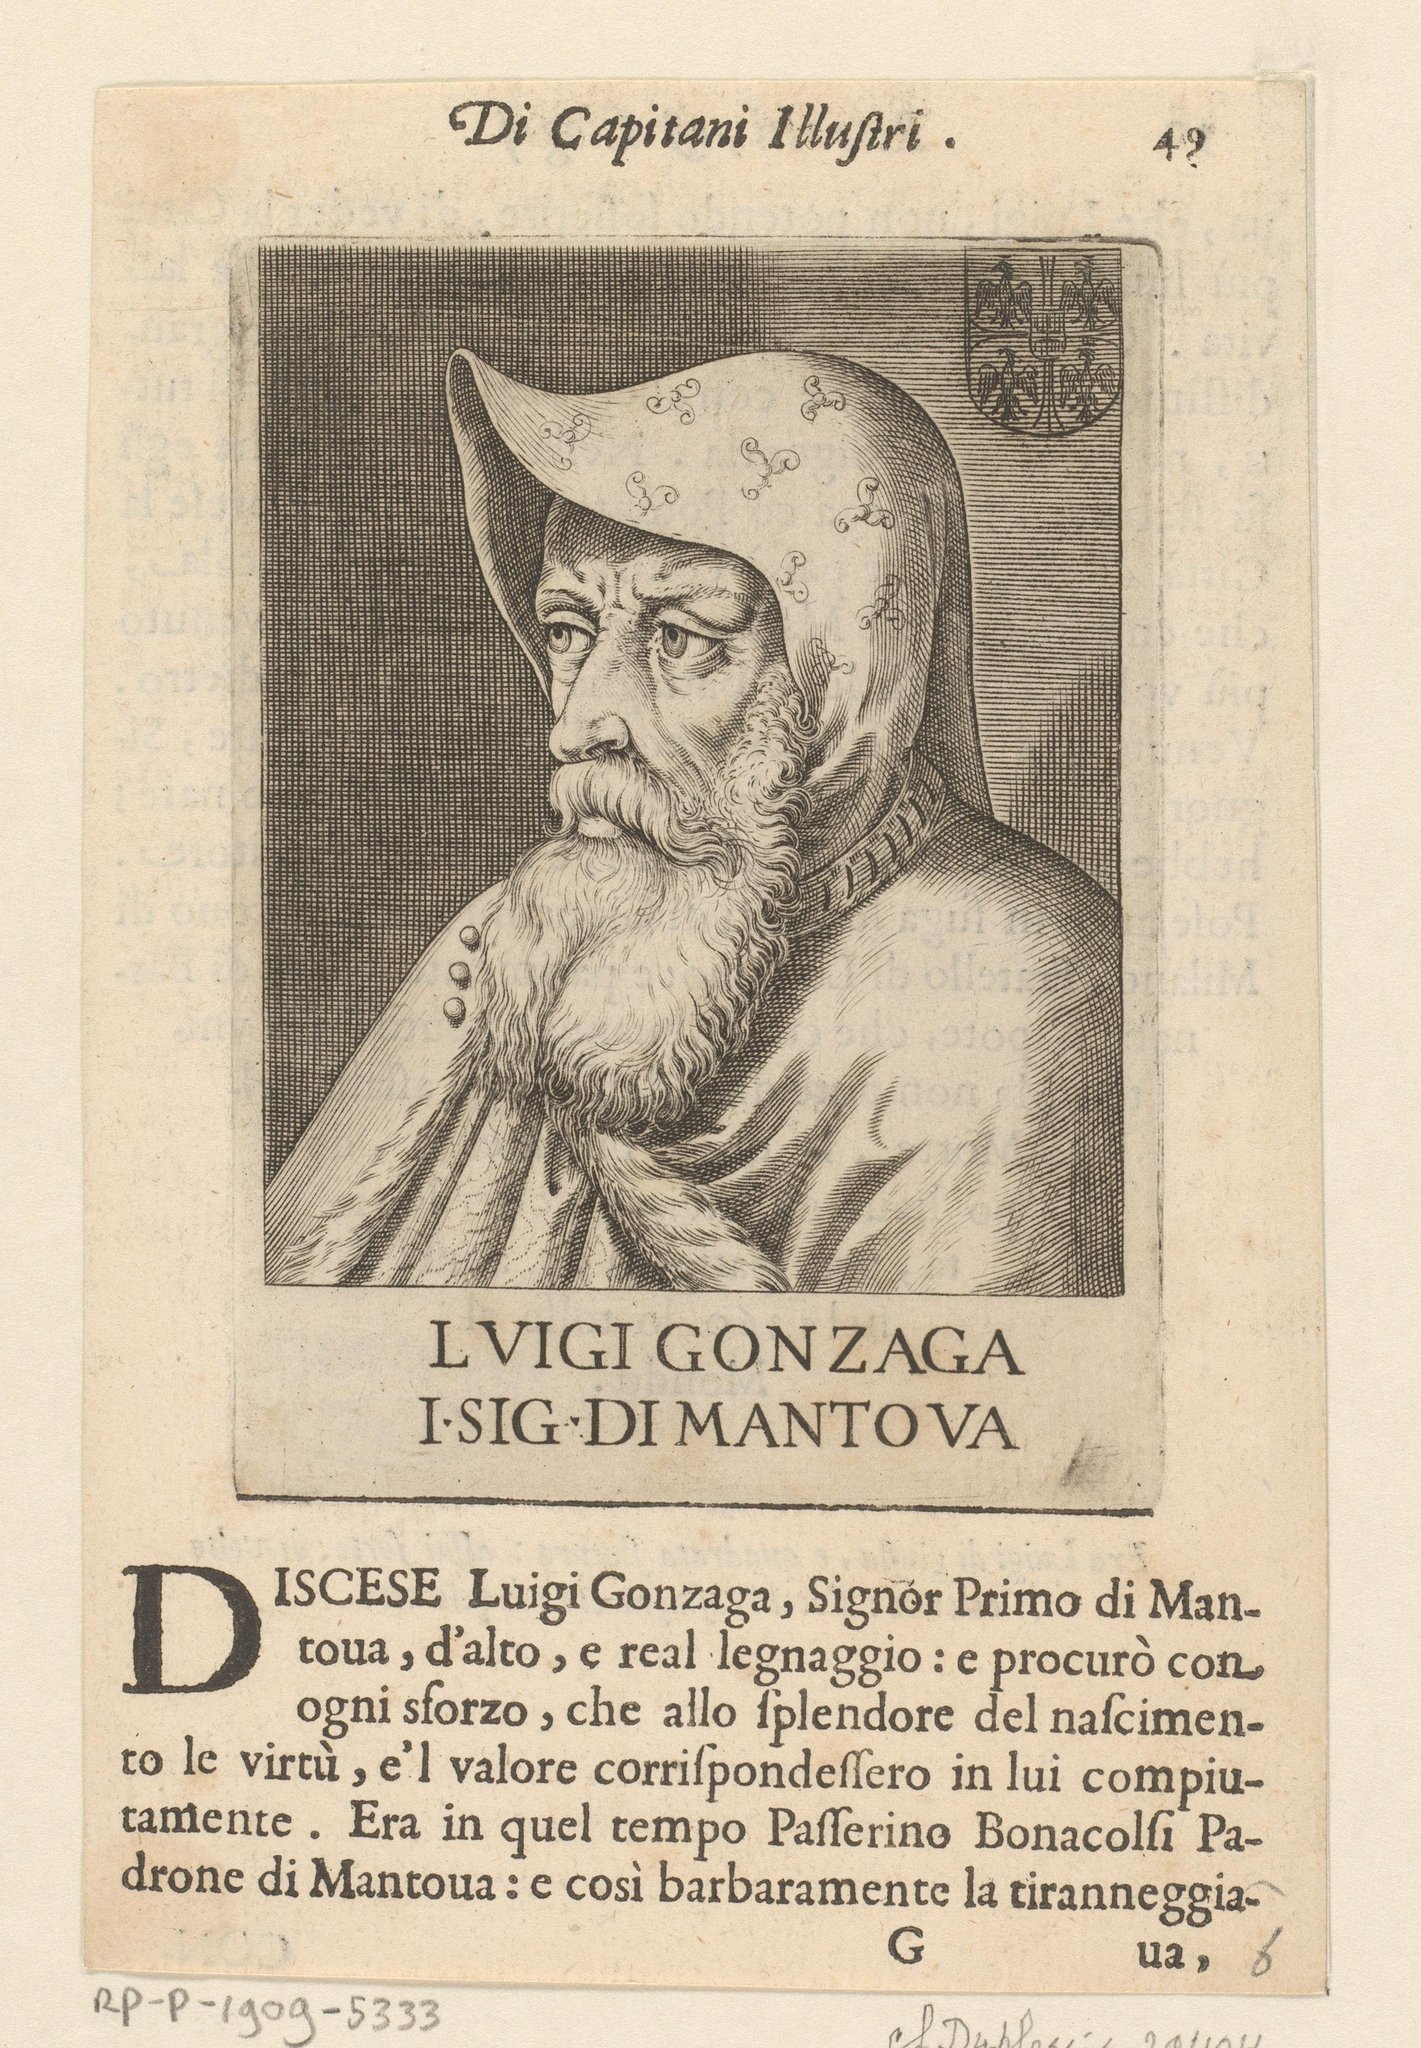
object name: print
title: Portret van rijksvoogd Ludovico Gonzaga I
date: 1646-1647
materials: paper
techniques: engraving, letterpress printing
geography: rome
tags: historical persons, armorial bearing, heraldry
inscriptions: collector's mark: Lugt 2228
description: Prent uit: Ritratti et elogii di capitani Illustri. Che ne'secoli moderni hanno gloriosamente guerreggiato. Rome: Filippo de'Rossi en Vitale Mascardi, 1646, p. 49. Prent ook gebruikt in dezelfde editie van 1647. Eerdere staten van prent in ieder geval gebruikt in: Ritratti et elogii di capitani Illustri. Rome: Pompilio Totti en Andrea Fei, 1635. En in: Ritratti di cento capitani illustri con li lor Fatti in guerra (…), Rome: Domenico Gigliotti, 1596.